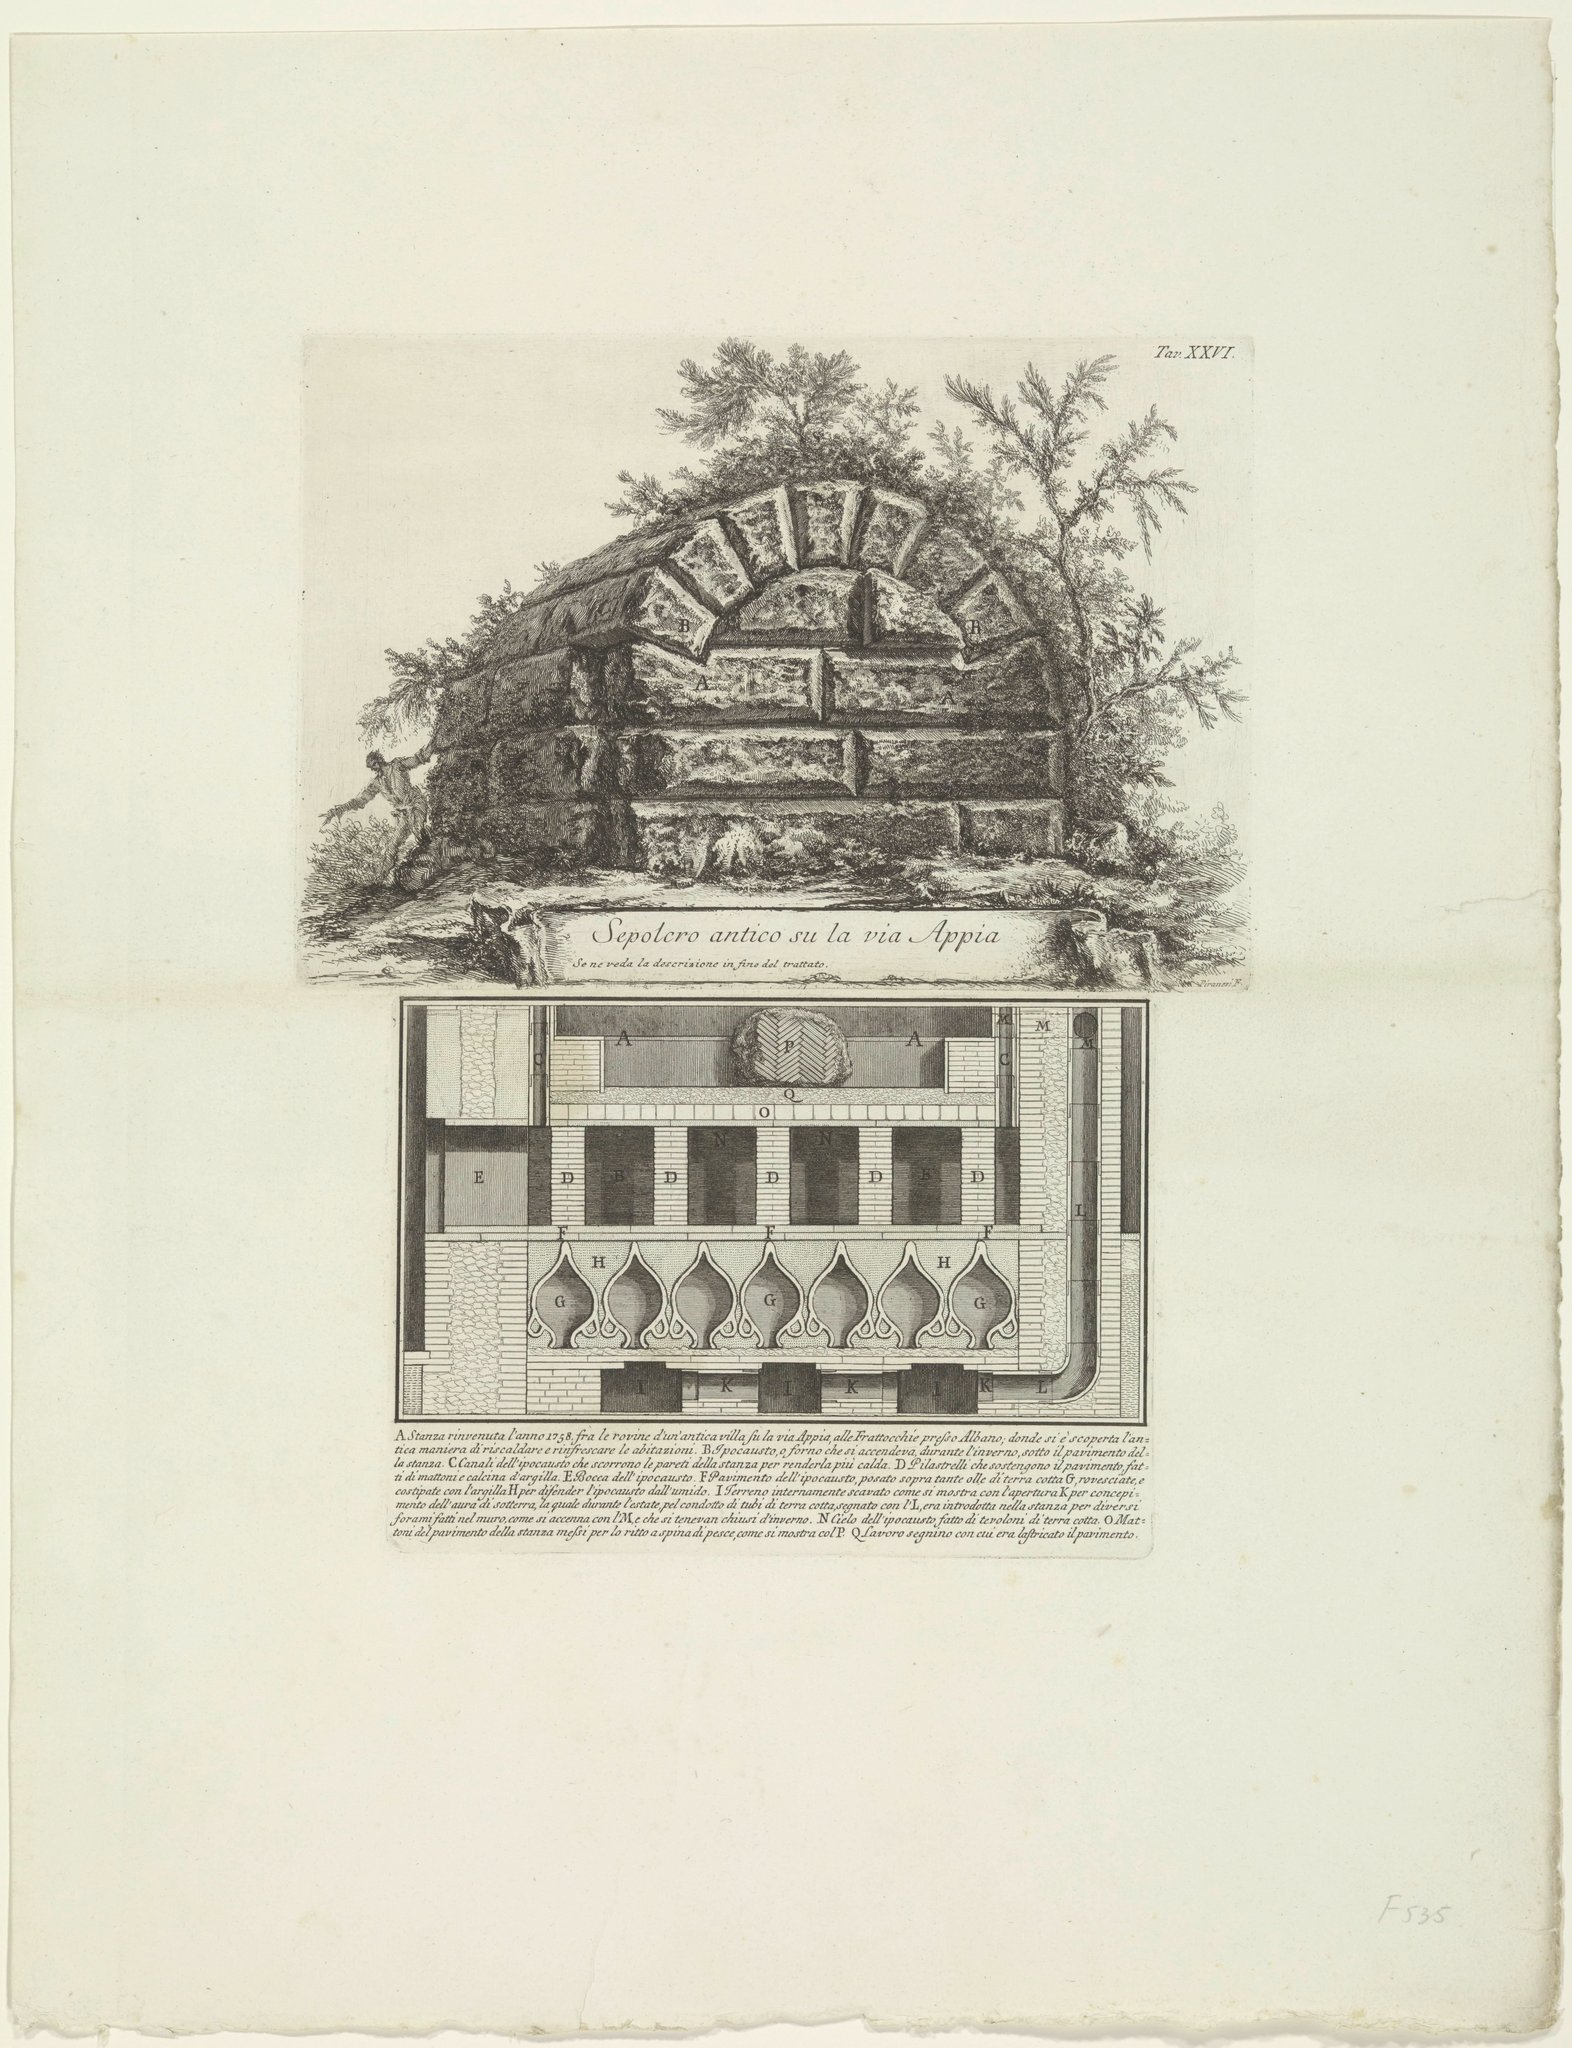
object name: print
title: Antichità d'Albano e di Castel Gandolfo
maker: giovanni battista piranesi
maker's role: designer, draughtsman, print maker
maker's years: 1720-1778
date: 1762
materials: paper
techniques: etching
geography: rome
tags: ruin of a building ~ architecture, grave, tomb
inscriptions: collector's mark: Lugt 2228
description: Blad met twee voorstellingen van bouwwerken langs de Via Appia Antica. Boven: gezicht op een graftombe. Titel en opmerking in ondermarge. Genummerd rechtsboven: Tav. XXVI. Onder: een ondergronds systeem ter verwarming en verkoeling van de kamer midden boven. Volgens de verklarende lijst met letters in de ondermarge bevindt het systeem zich onder de ruïnes van een villa aan de Via Appia ter hoogte van de plaats Frattocchie.